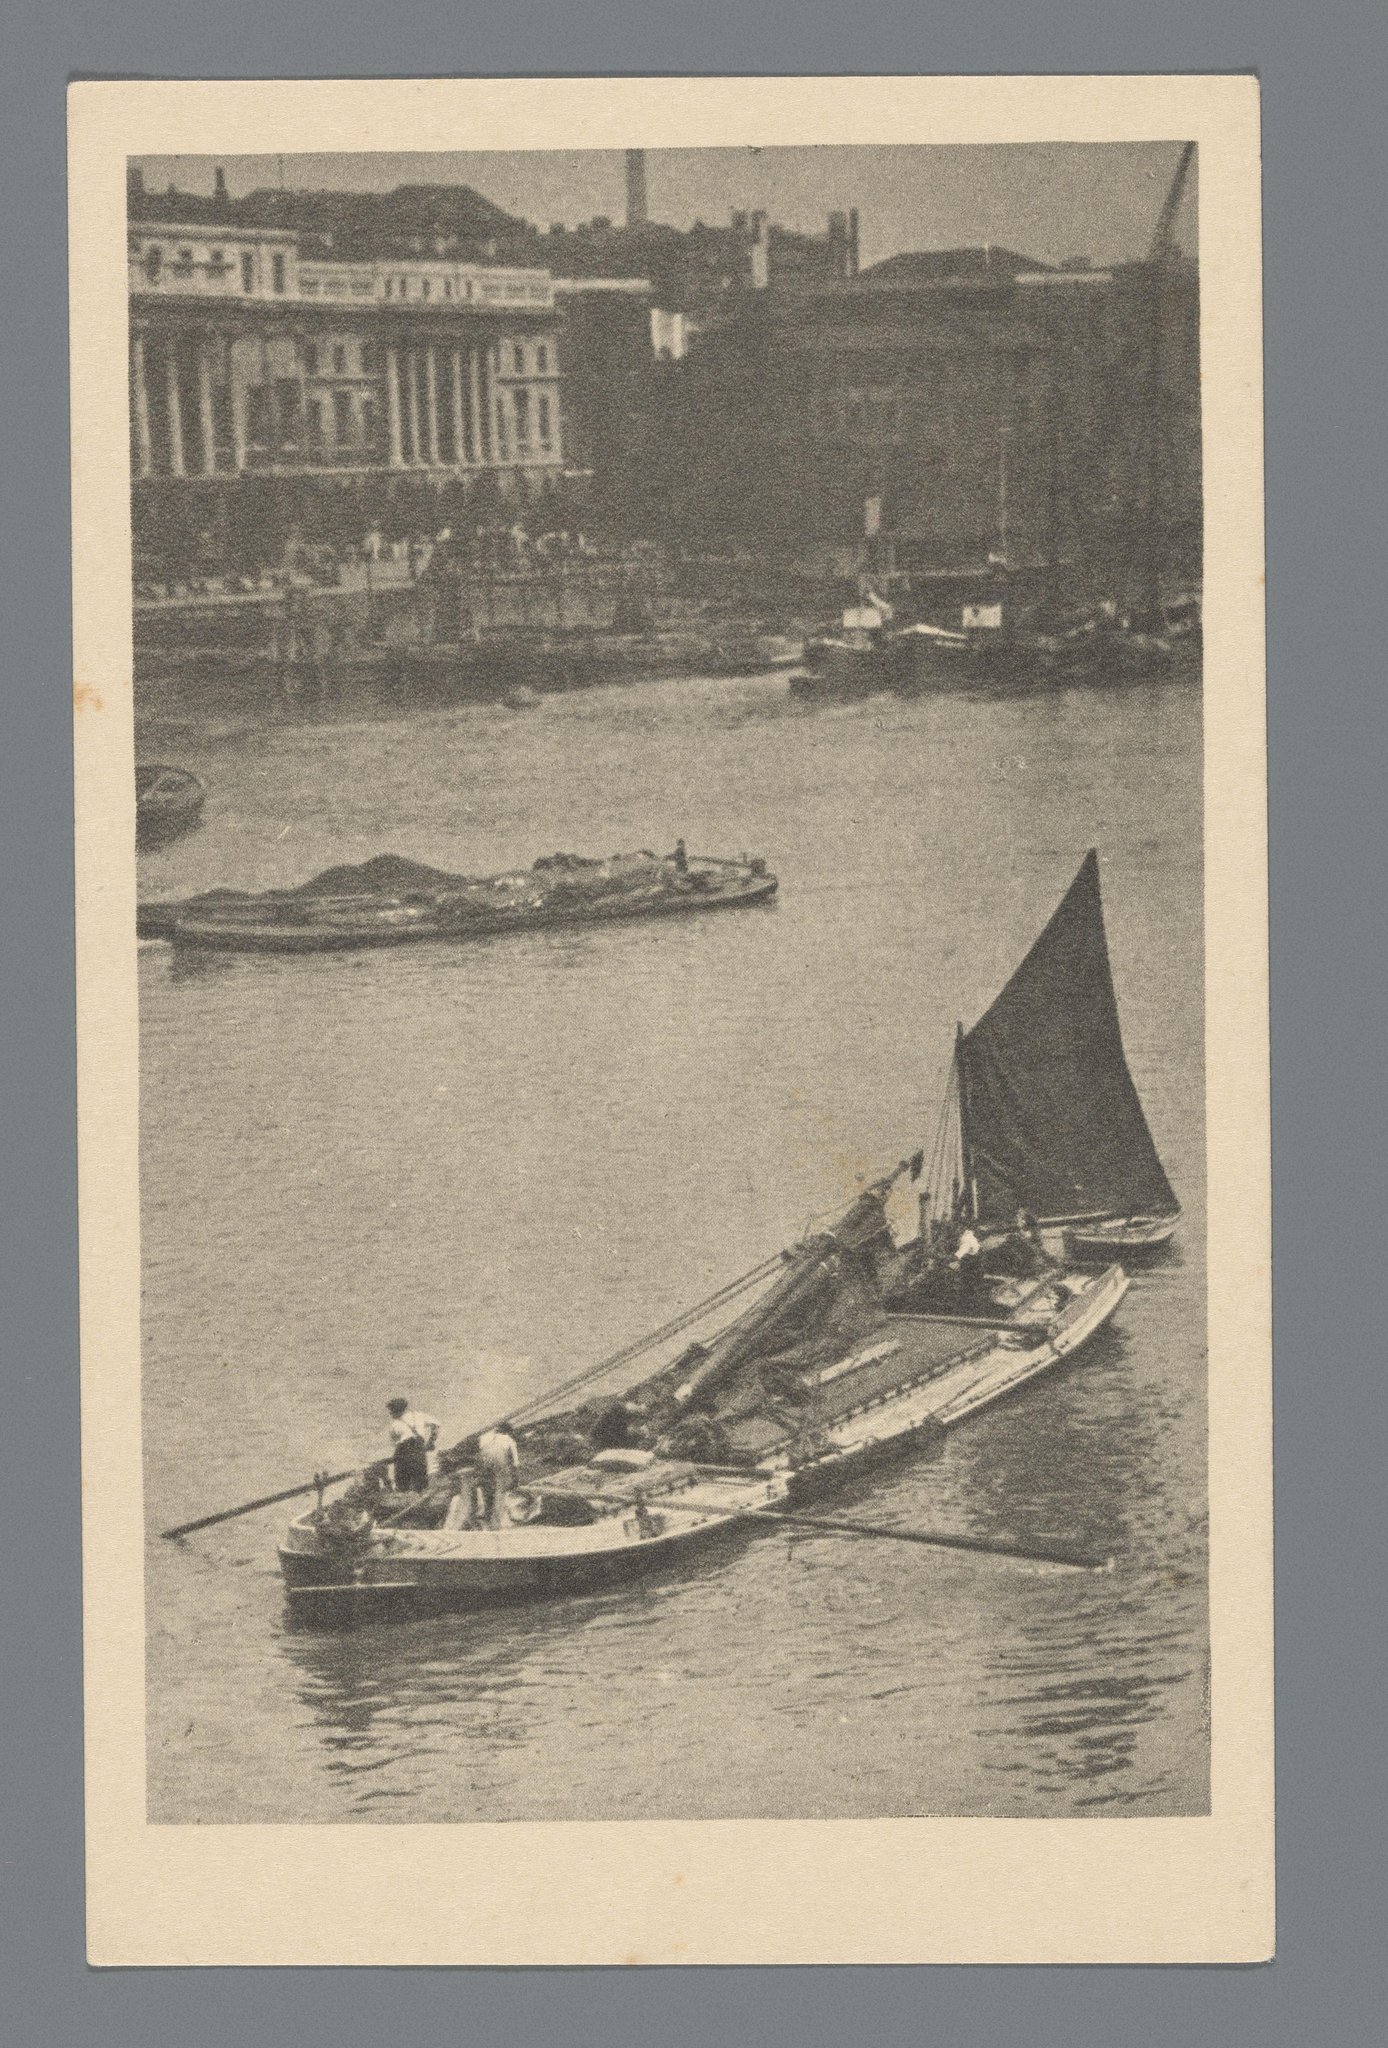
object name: ansichtkaart, prentbriefkaart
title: Gezicht op Custom House aan de Theems met boten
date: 1914-2024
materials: cardboard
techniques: photoaquatint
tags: river, tow-boat, towing-barge, names of historical buildings, sites, streets, etc.